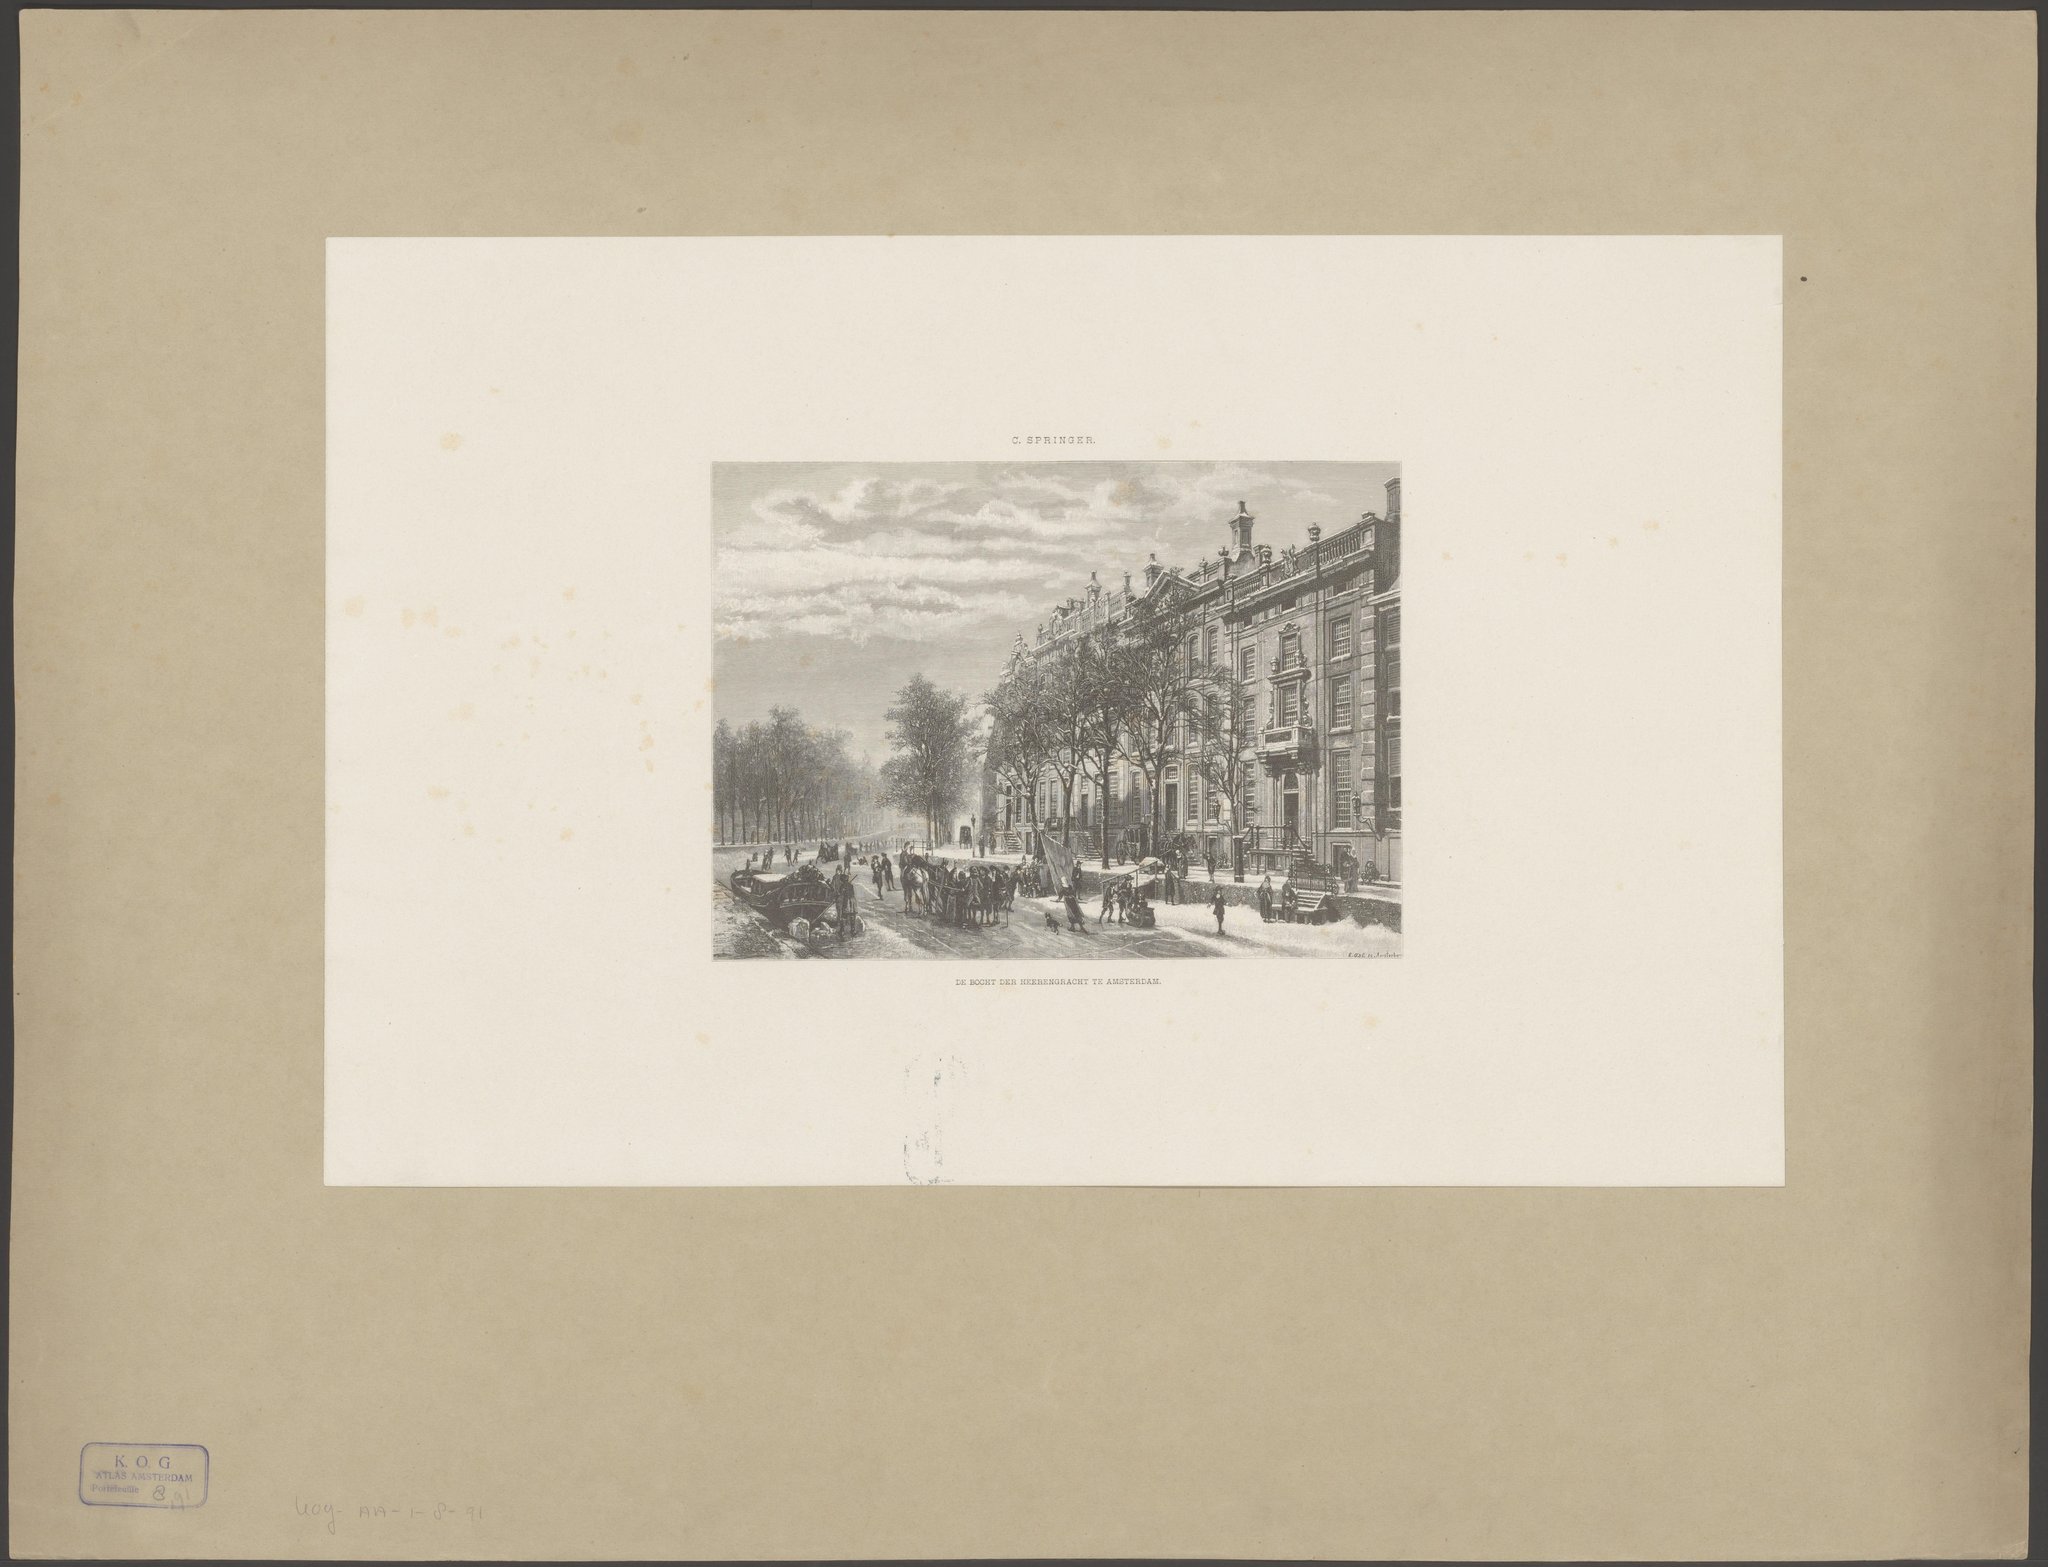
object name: print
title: Wintergezicht op de Herengracht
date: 1856-1899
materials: paper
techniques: letterpress printing, engraving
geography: amsterdam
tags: city-view in general; 'veduta', canal, winter landscape; landscape symbolizing winter (the four seasons of the year), skates (winter sports), bridge in city across river, canal, etc., street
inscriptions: collector's mark: ‘8,91’ Lugt 1641b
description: Onderwerpsrubriek binnen de Atlas Amsterdam: Haarlemmerplein, Halvemaansteeg, Handboogstraat, Handelskade, Haringpakkerij, Hartenstraat, Hasseltsteeg (Dirk van), Heerengracht.